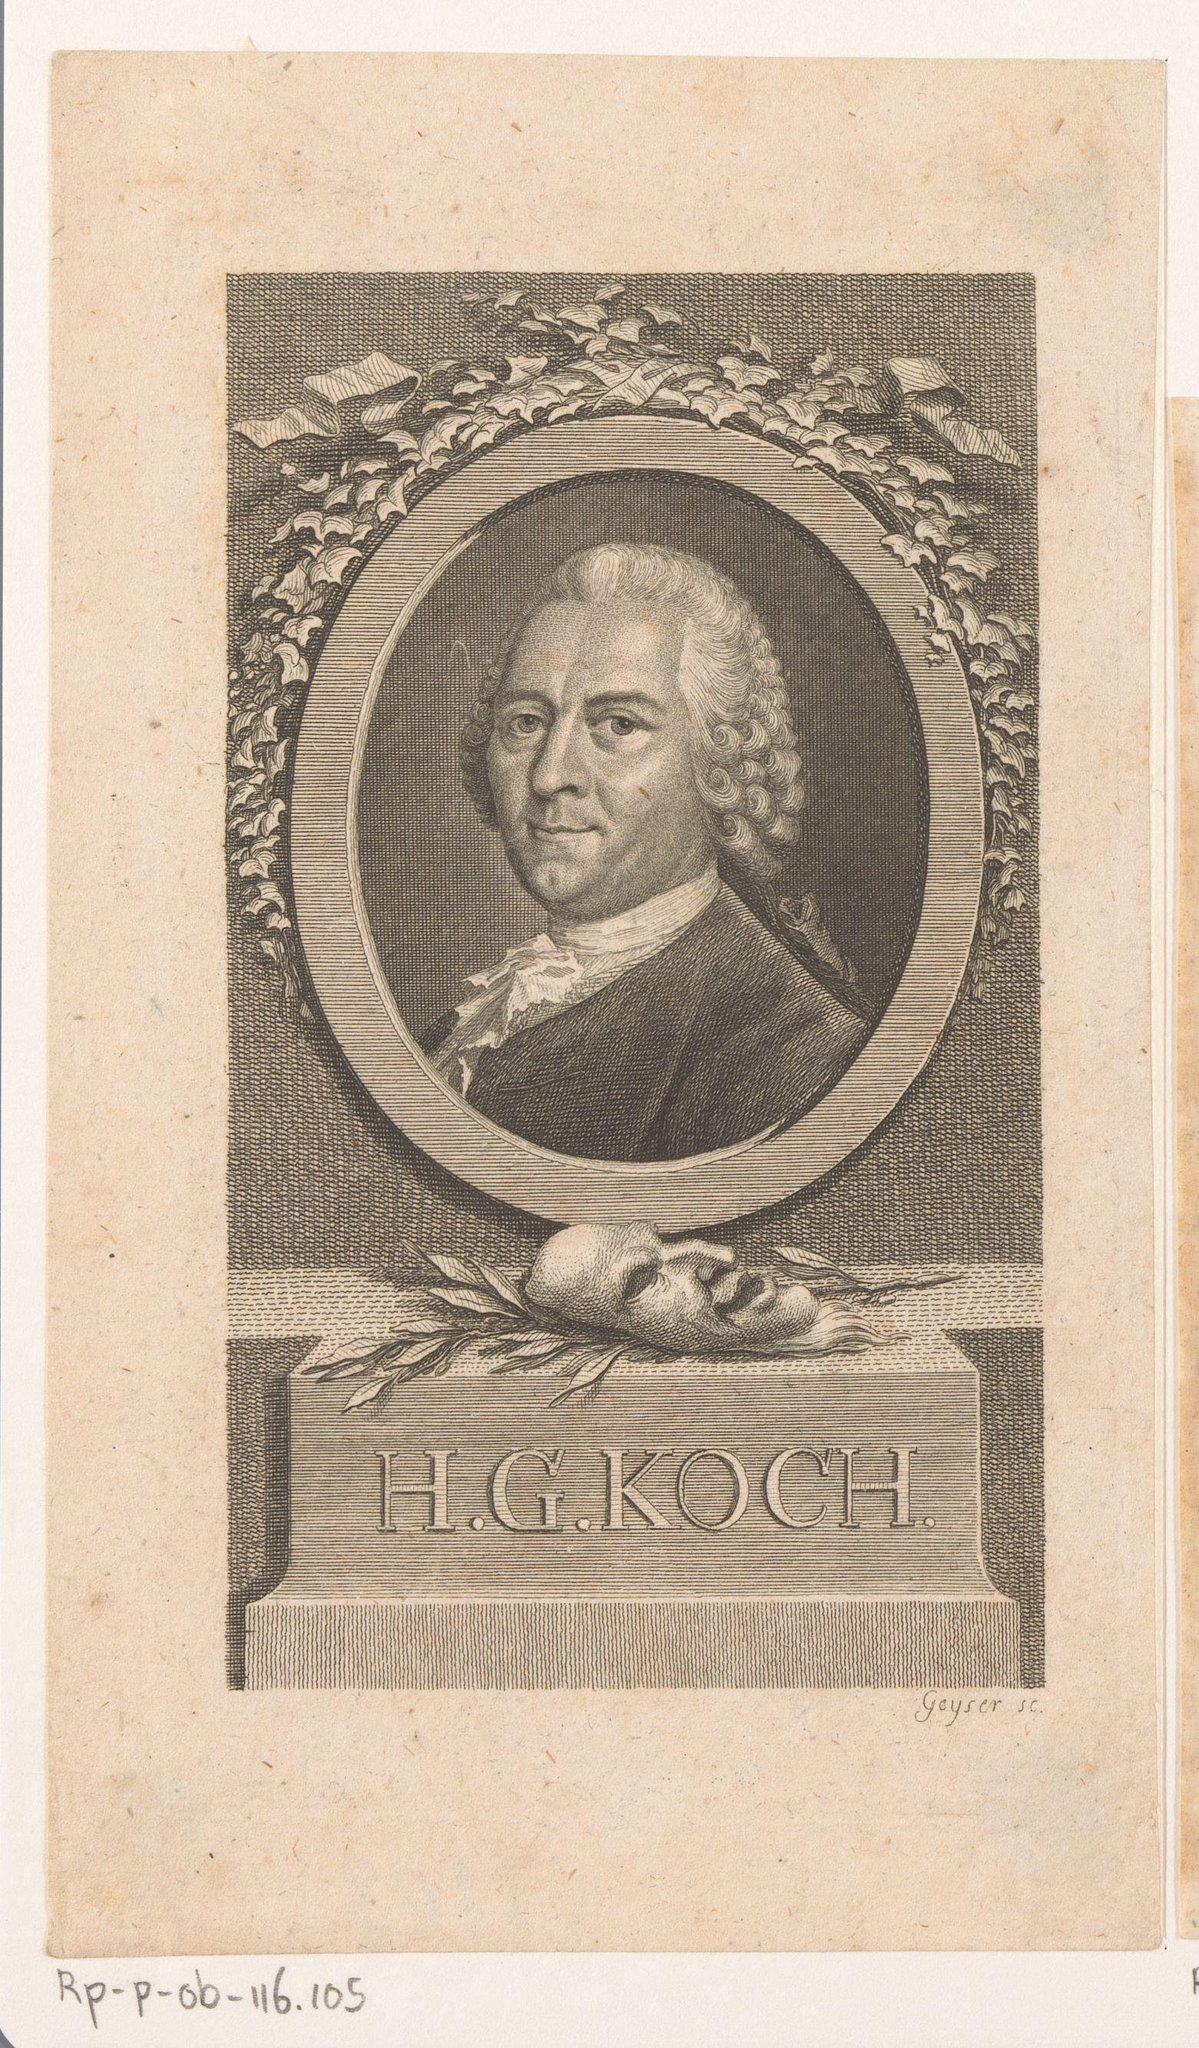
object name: print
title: Portret van Heinrich Gottfried Koch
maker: christian gottlieb geyser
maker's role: print maker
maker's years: 1742-1803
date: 1752-1803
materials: paper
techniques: engraving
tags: berlin, mask, historical persons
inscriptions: collector's mark: Lugt 2228